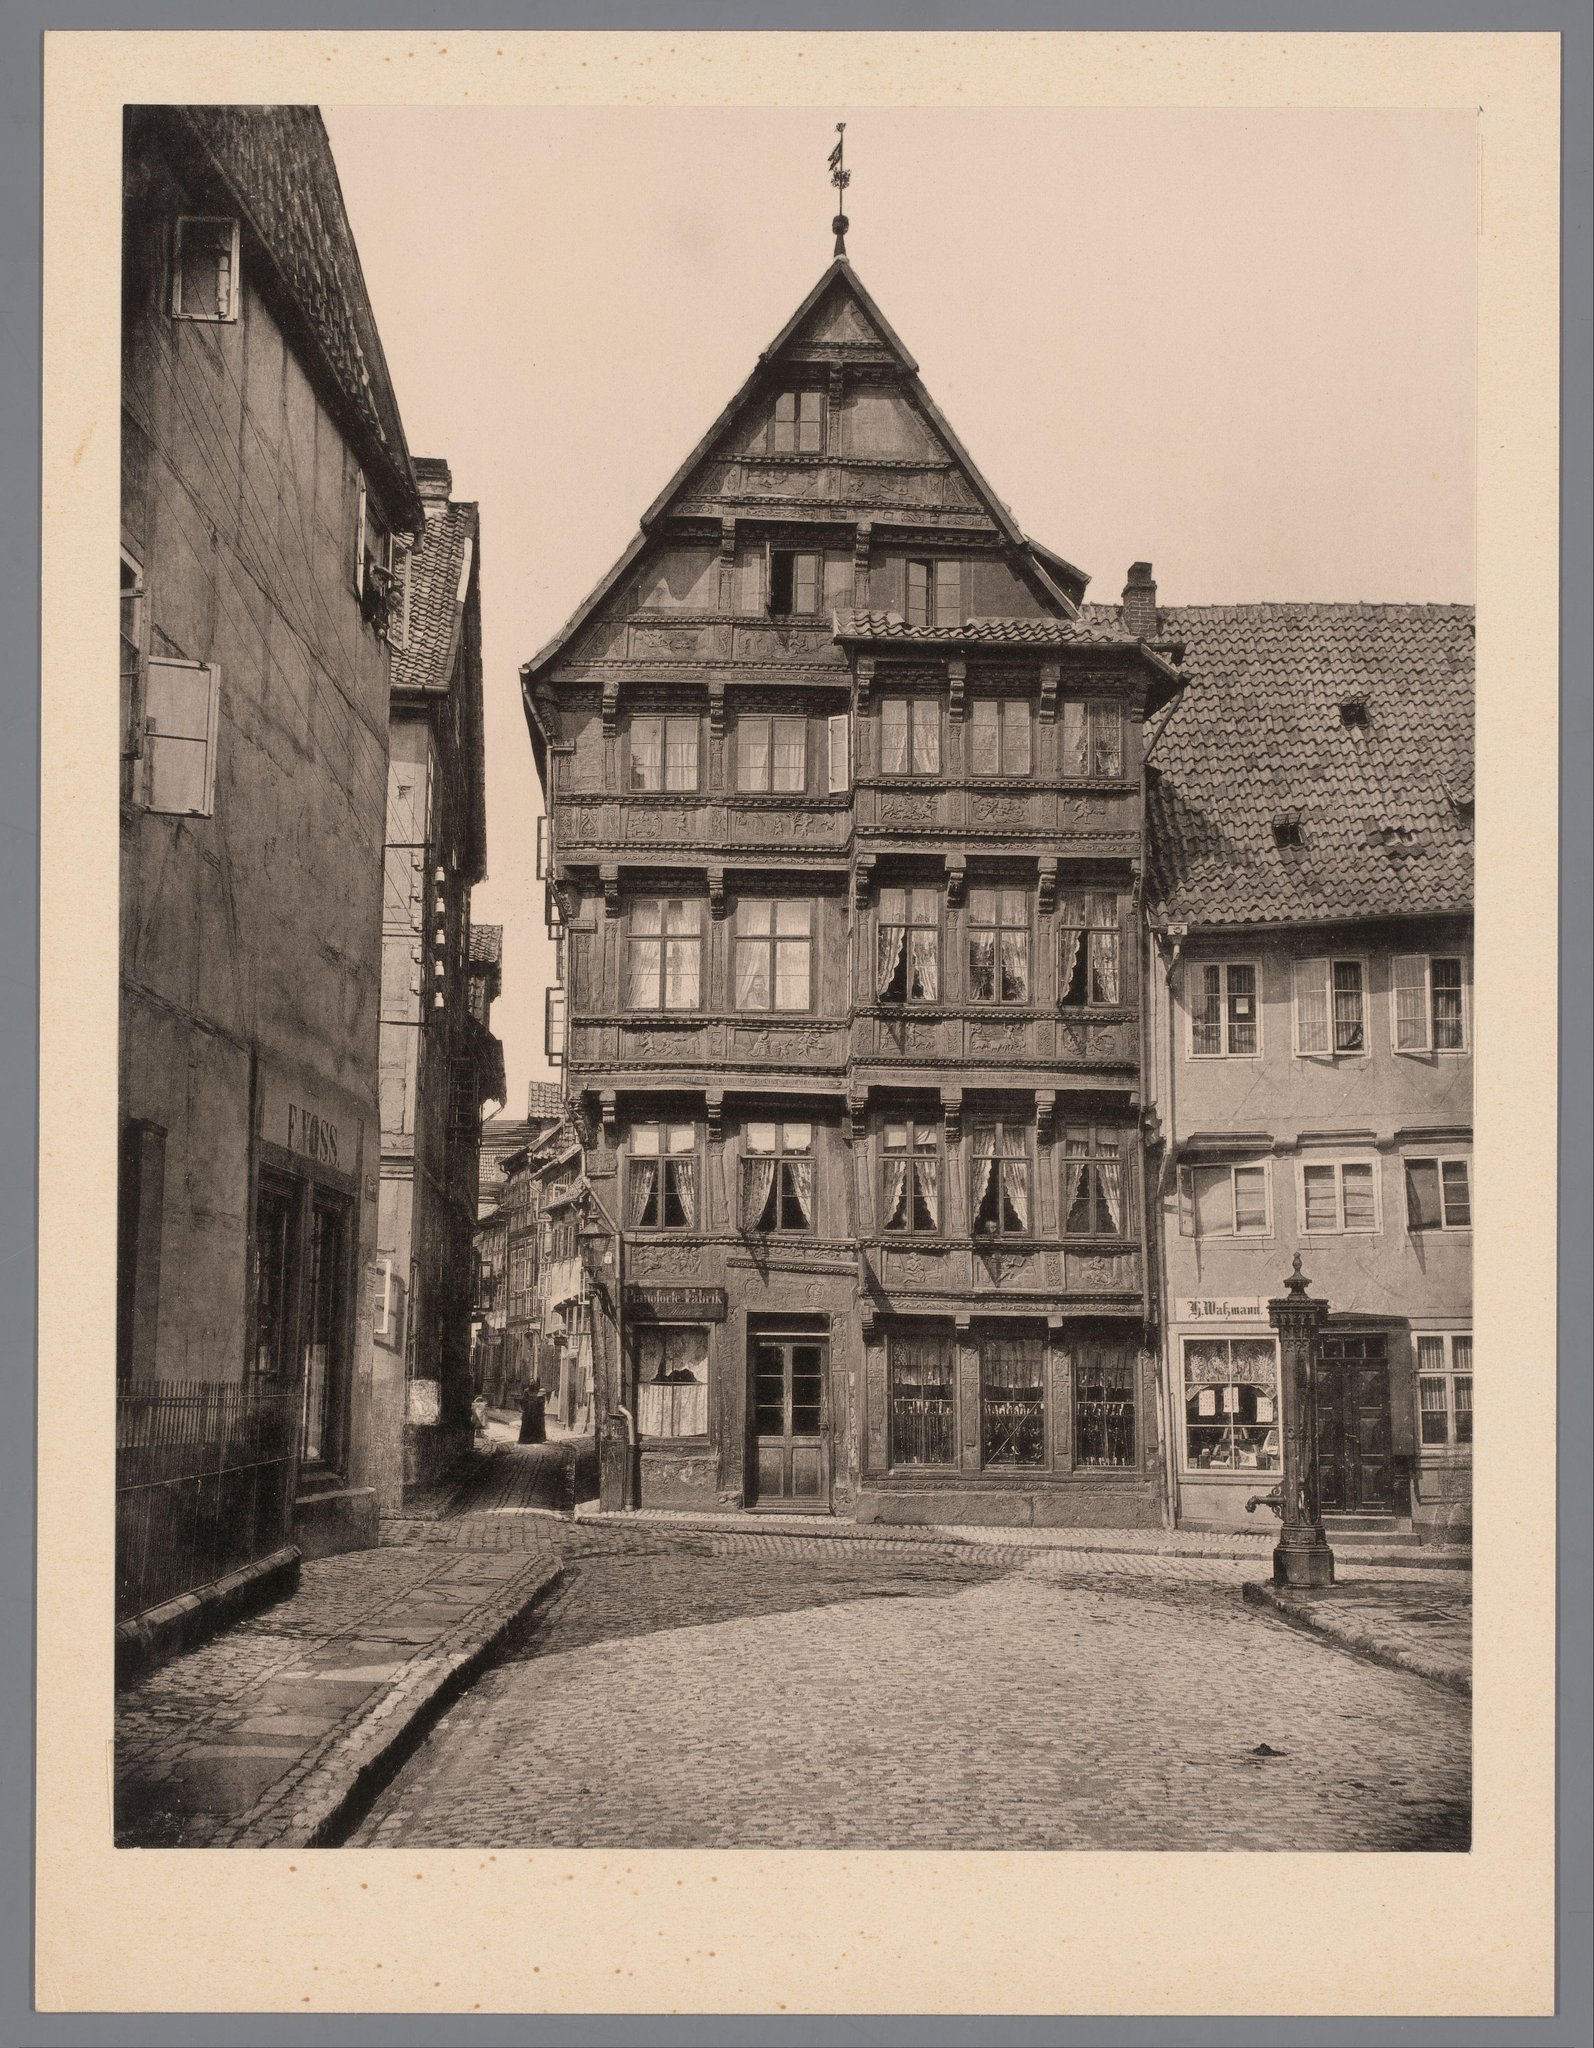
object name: photomechanical print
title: Straat in Hildesheim, Duitsland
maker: Anonymous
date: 1870-1930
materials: cardboard, paper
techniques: photograph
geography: hildesheim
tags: street